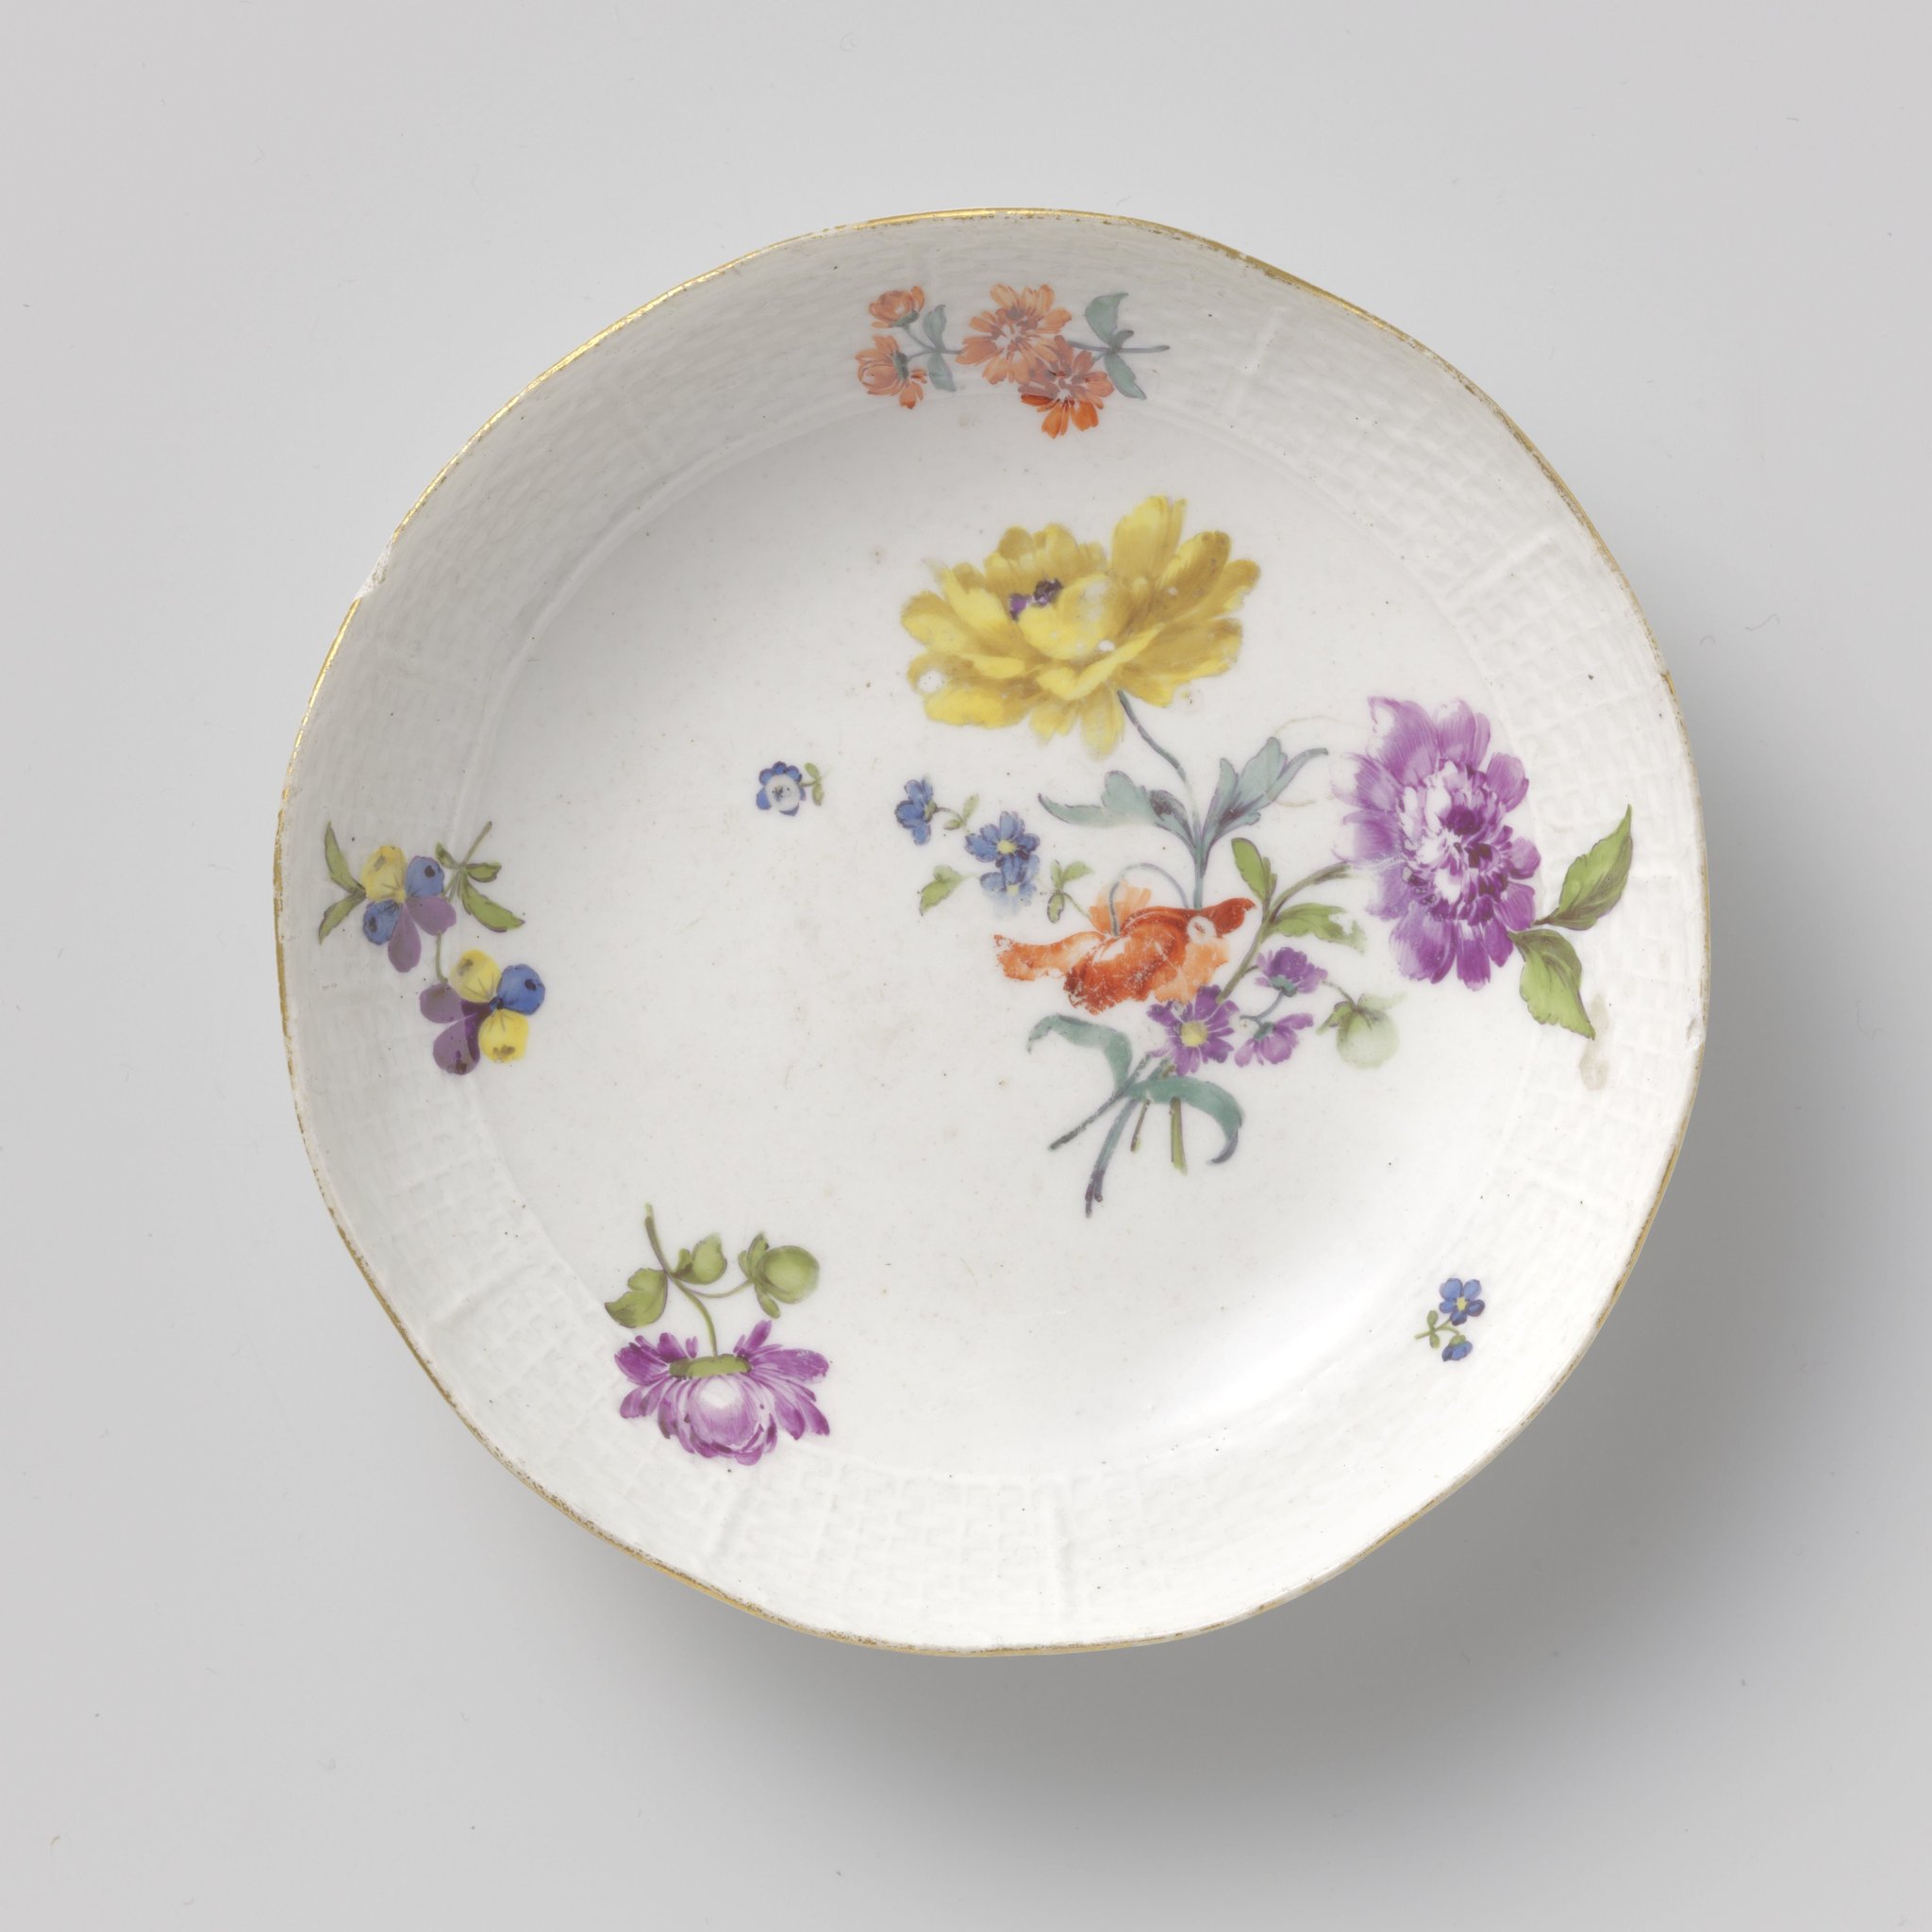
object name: eating drinking utensil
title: Schotel, veelkleurig beschilderd met bloemboeketten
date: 1750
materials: porcelain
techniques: painted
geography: meissen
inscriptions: factory mark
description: Ronde schotel van beschilderd porselein. De schotel is beschilderd met bloemboeketten en versierd met een Ozier-rand. De schotel is gemerkt.